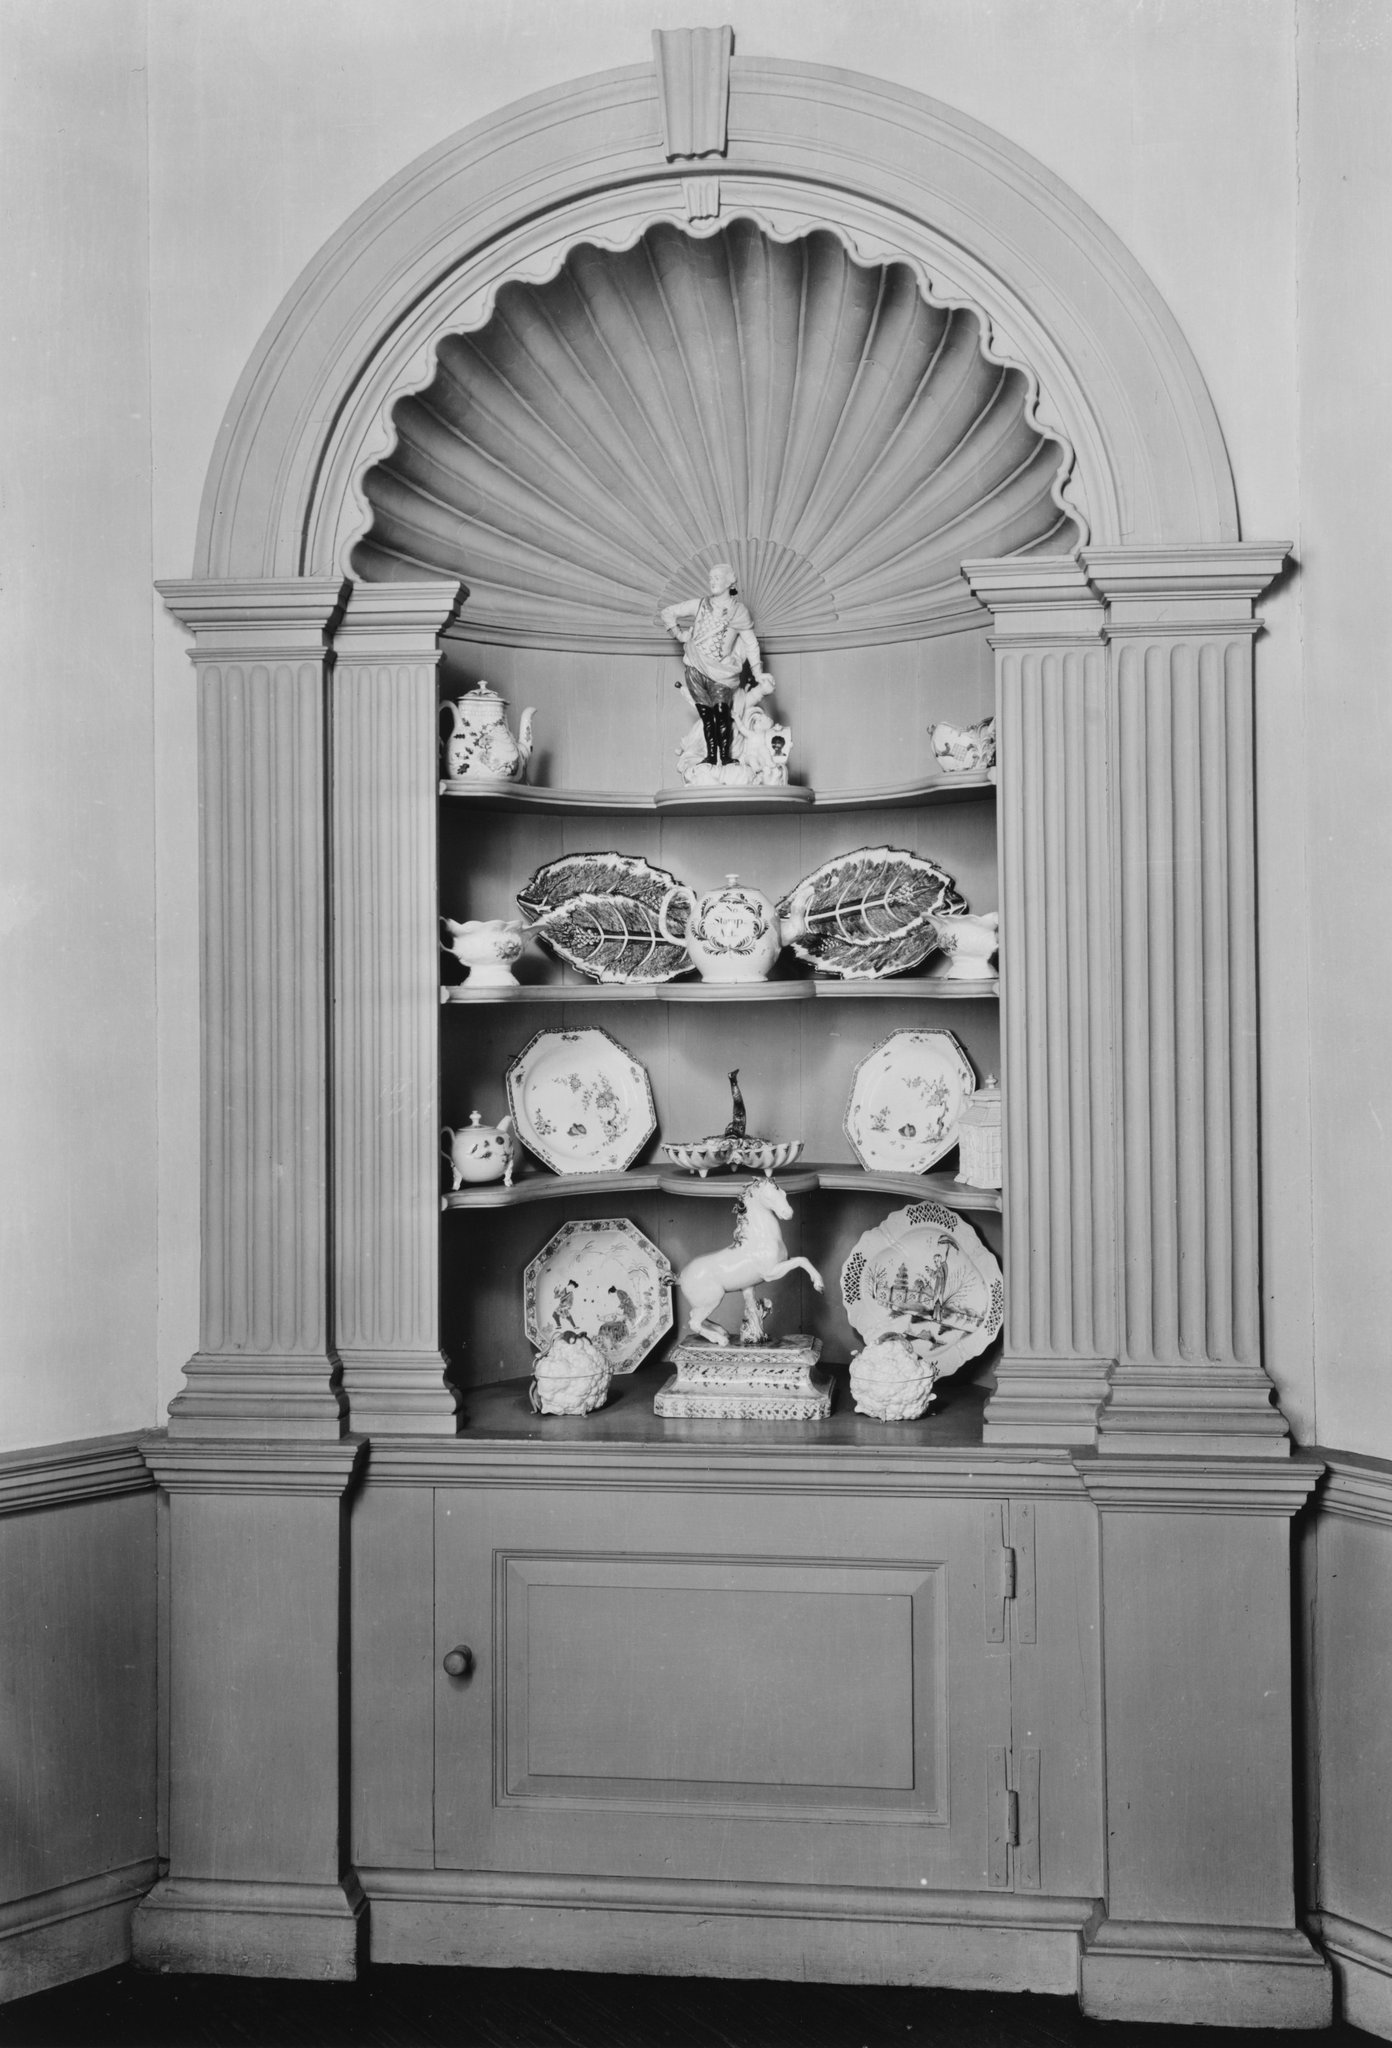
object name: cupboard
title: Corner Cupboard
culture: american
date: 1750-1800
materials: wood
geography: united states